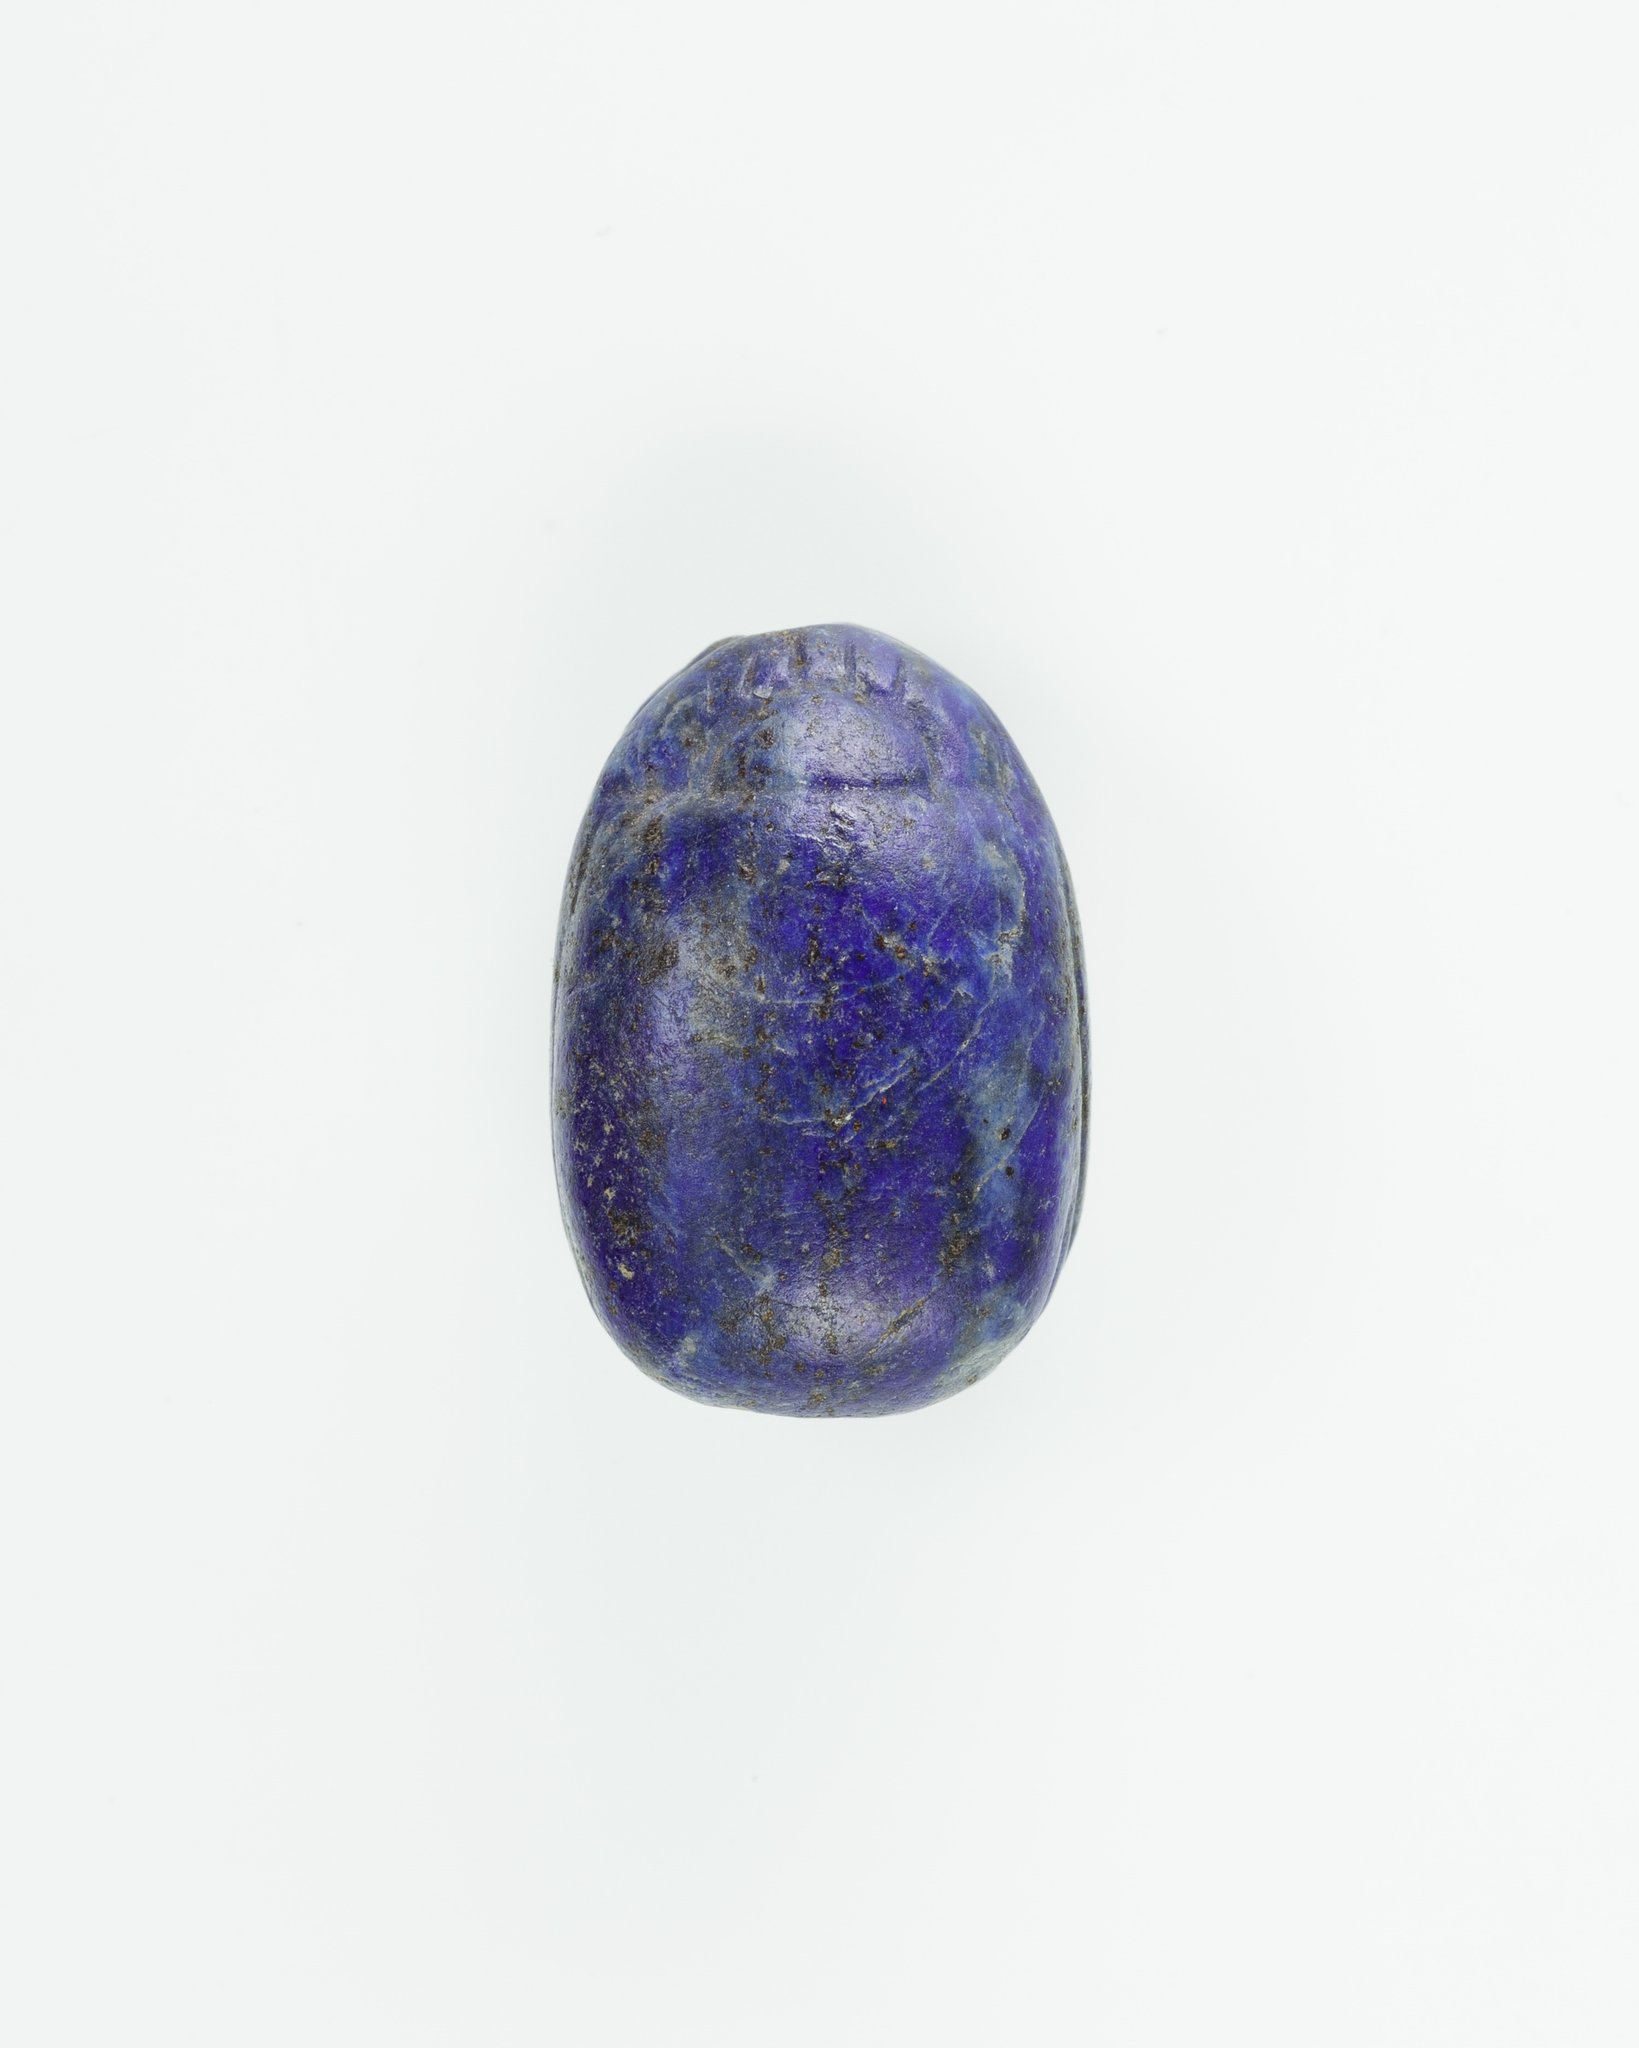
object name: scarab, uninscribed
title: Uninscribed scarab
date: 1850-1750 BCE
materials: lapis lazuli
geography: egypt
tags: scarabs